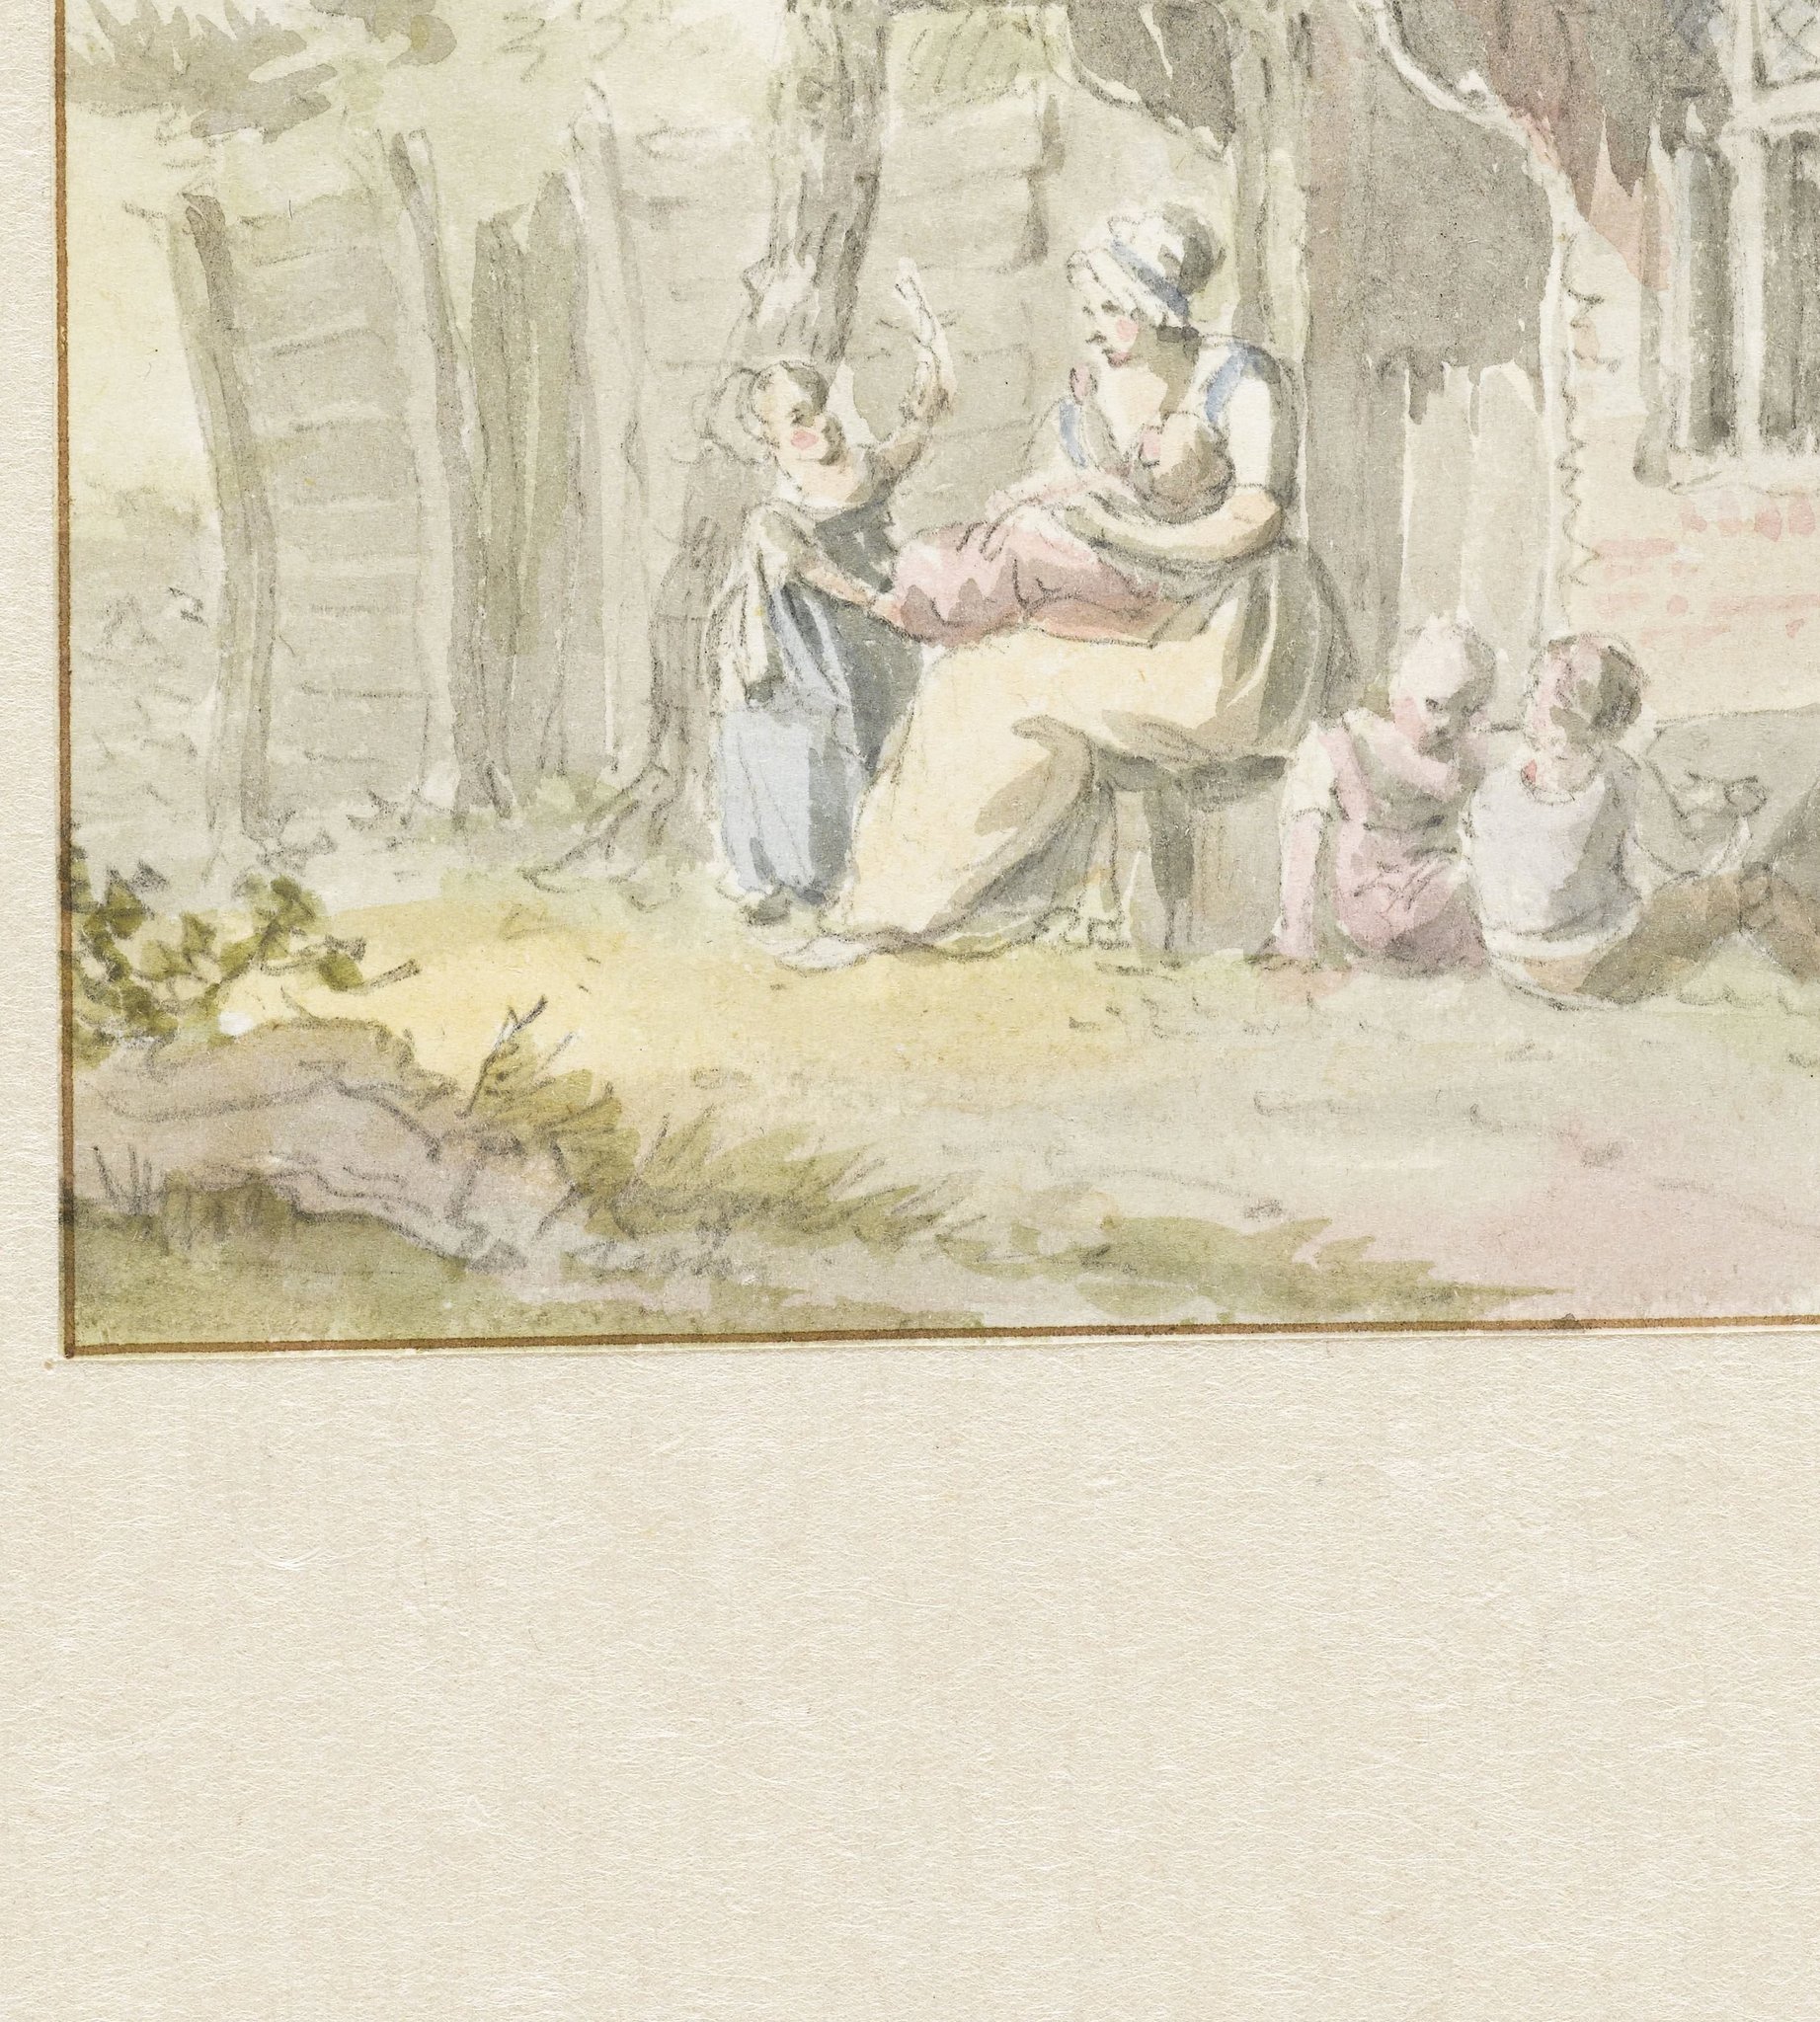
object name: watercolor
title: Moeder met kinderen zittend voor huis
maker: pieter bartholomeusz. barbiers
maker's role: draughtsman, print maker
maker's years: 1772-1837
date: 1782-1837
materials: graphite, paper, watercolor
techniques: brush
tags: mother and baby or young child